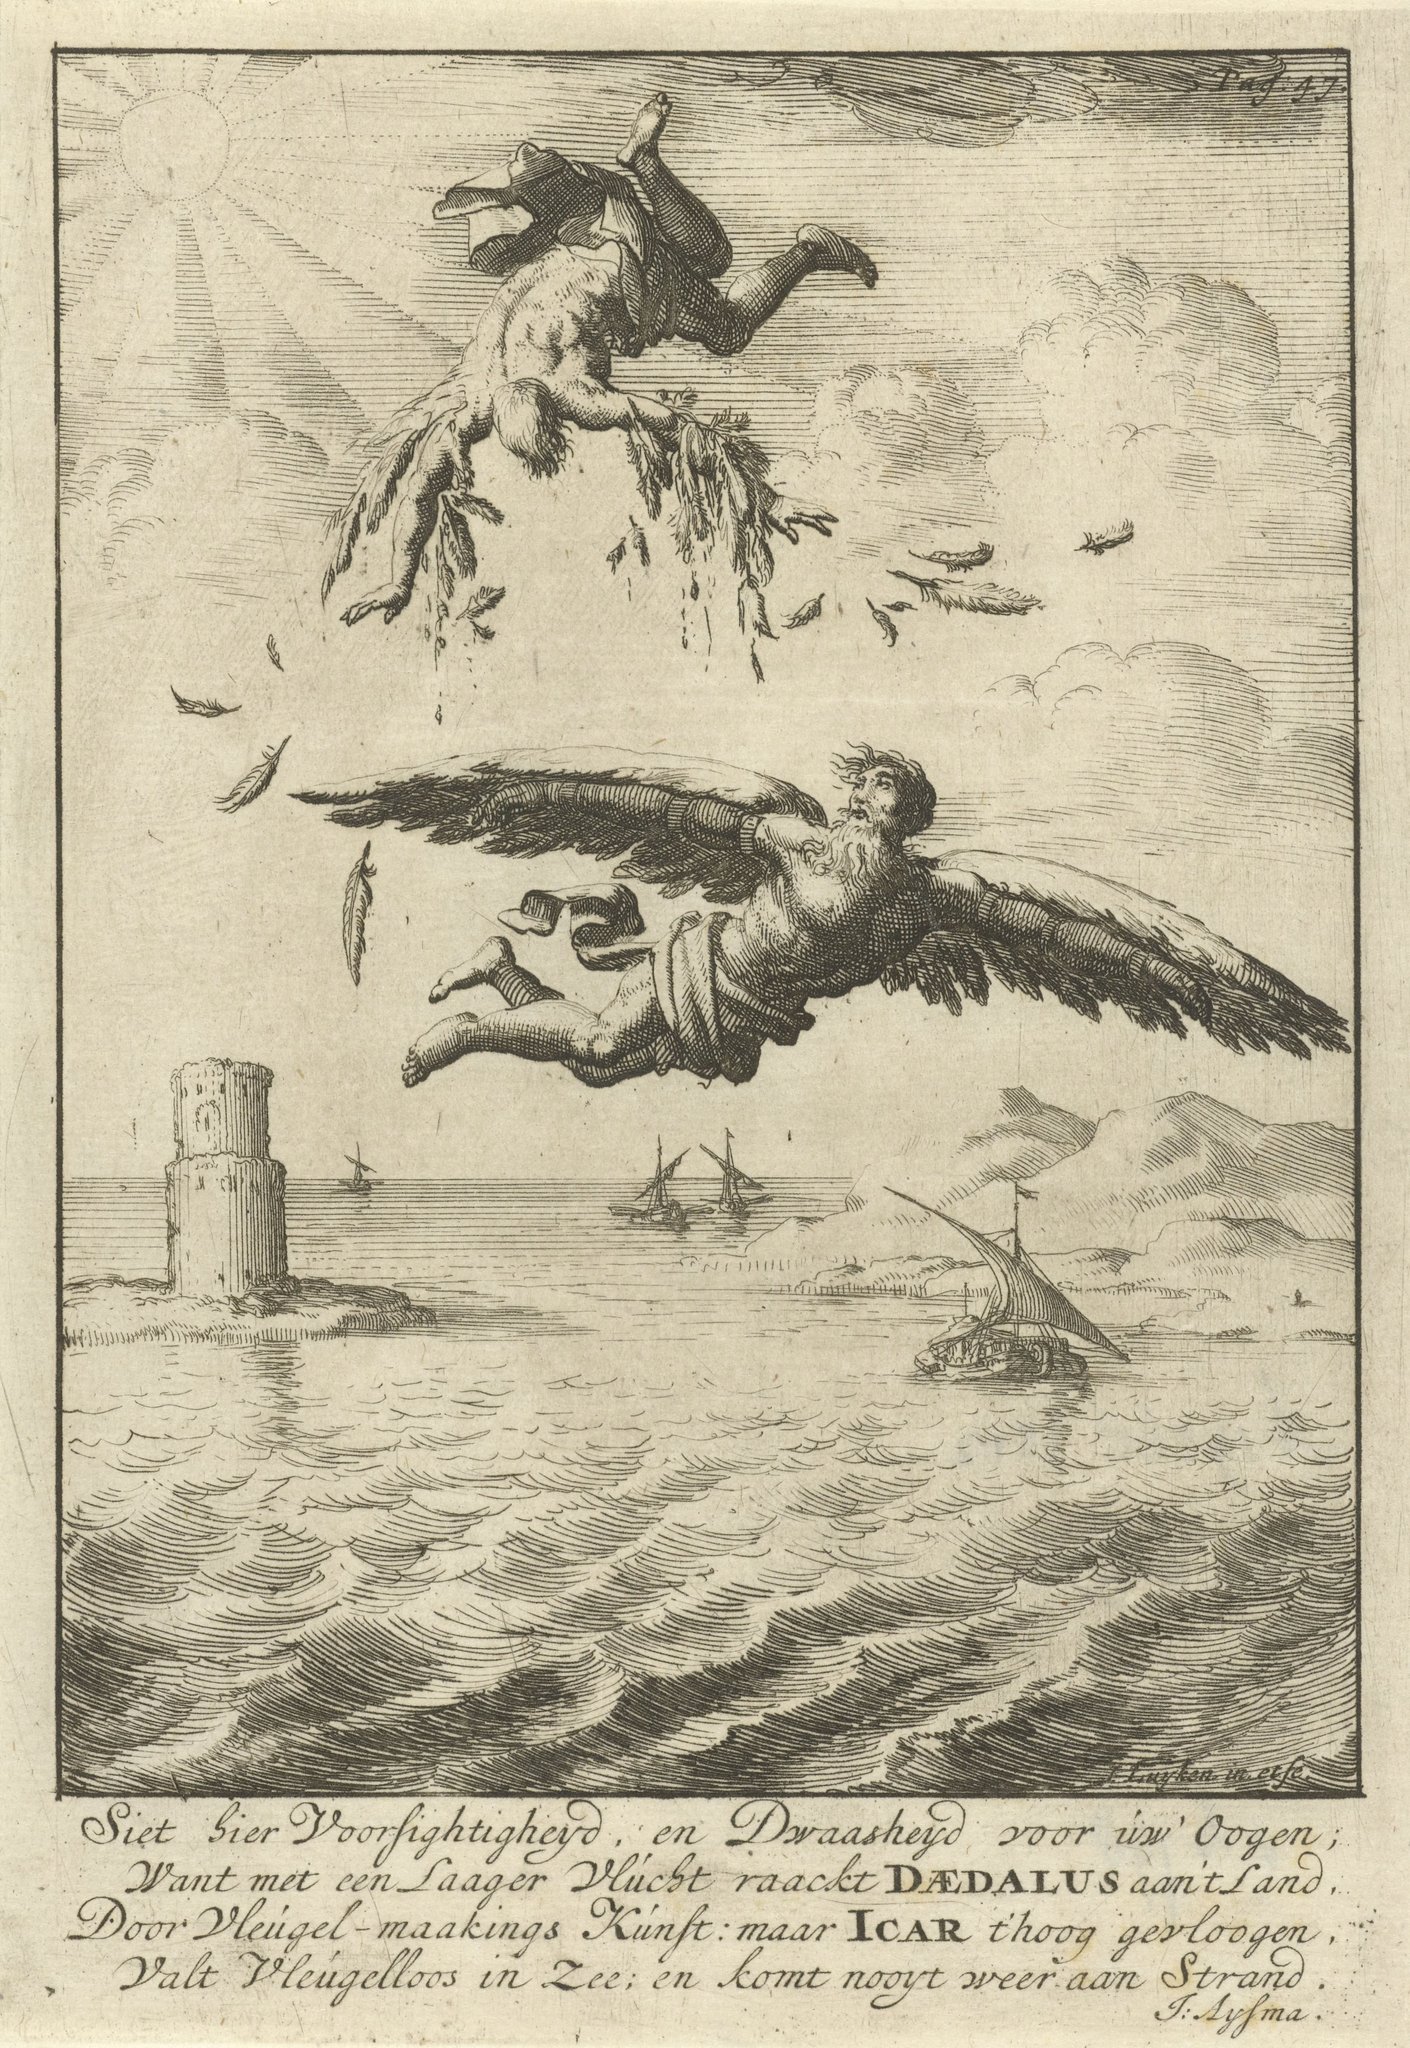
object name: print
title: Val van Icarus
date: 1686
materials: paper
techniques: etching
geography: amsterdam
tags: death i.e. the fall of icarus (daedalus present)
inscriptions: collector's mark: Lugt 2228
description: Illustratie uit: Aysma, Joannes. Het ryck der goden, onder den eenige waare God, 2 delen. Amsterdam: Timotheus ten Hoorn, 1686, dl. I, p. 47.